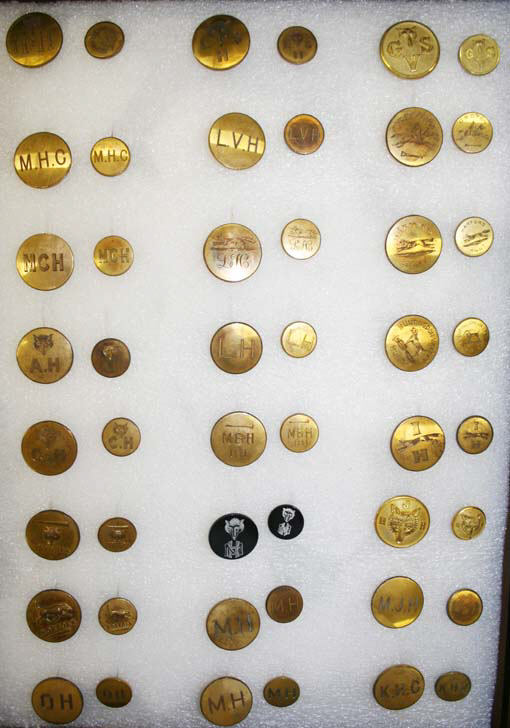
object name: button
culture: british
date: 1850-1880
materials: metal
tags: foxes